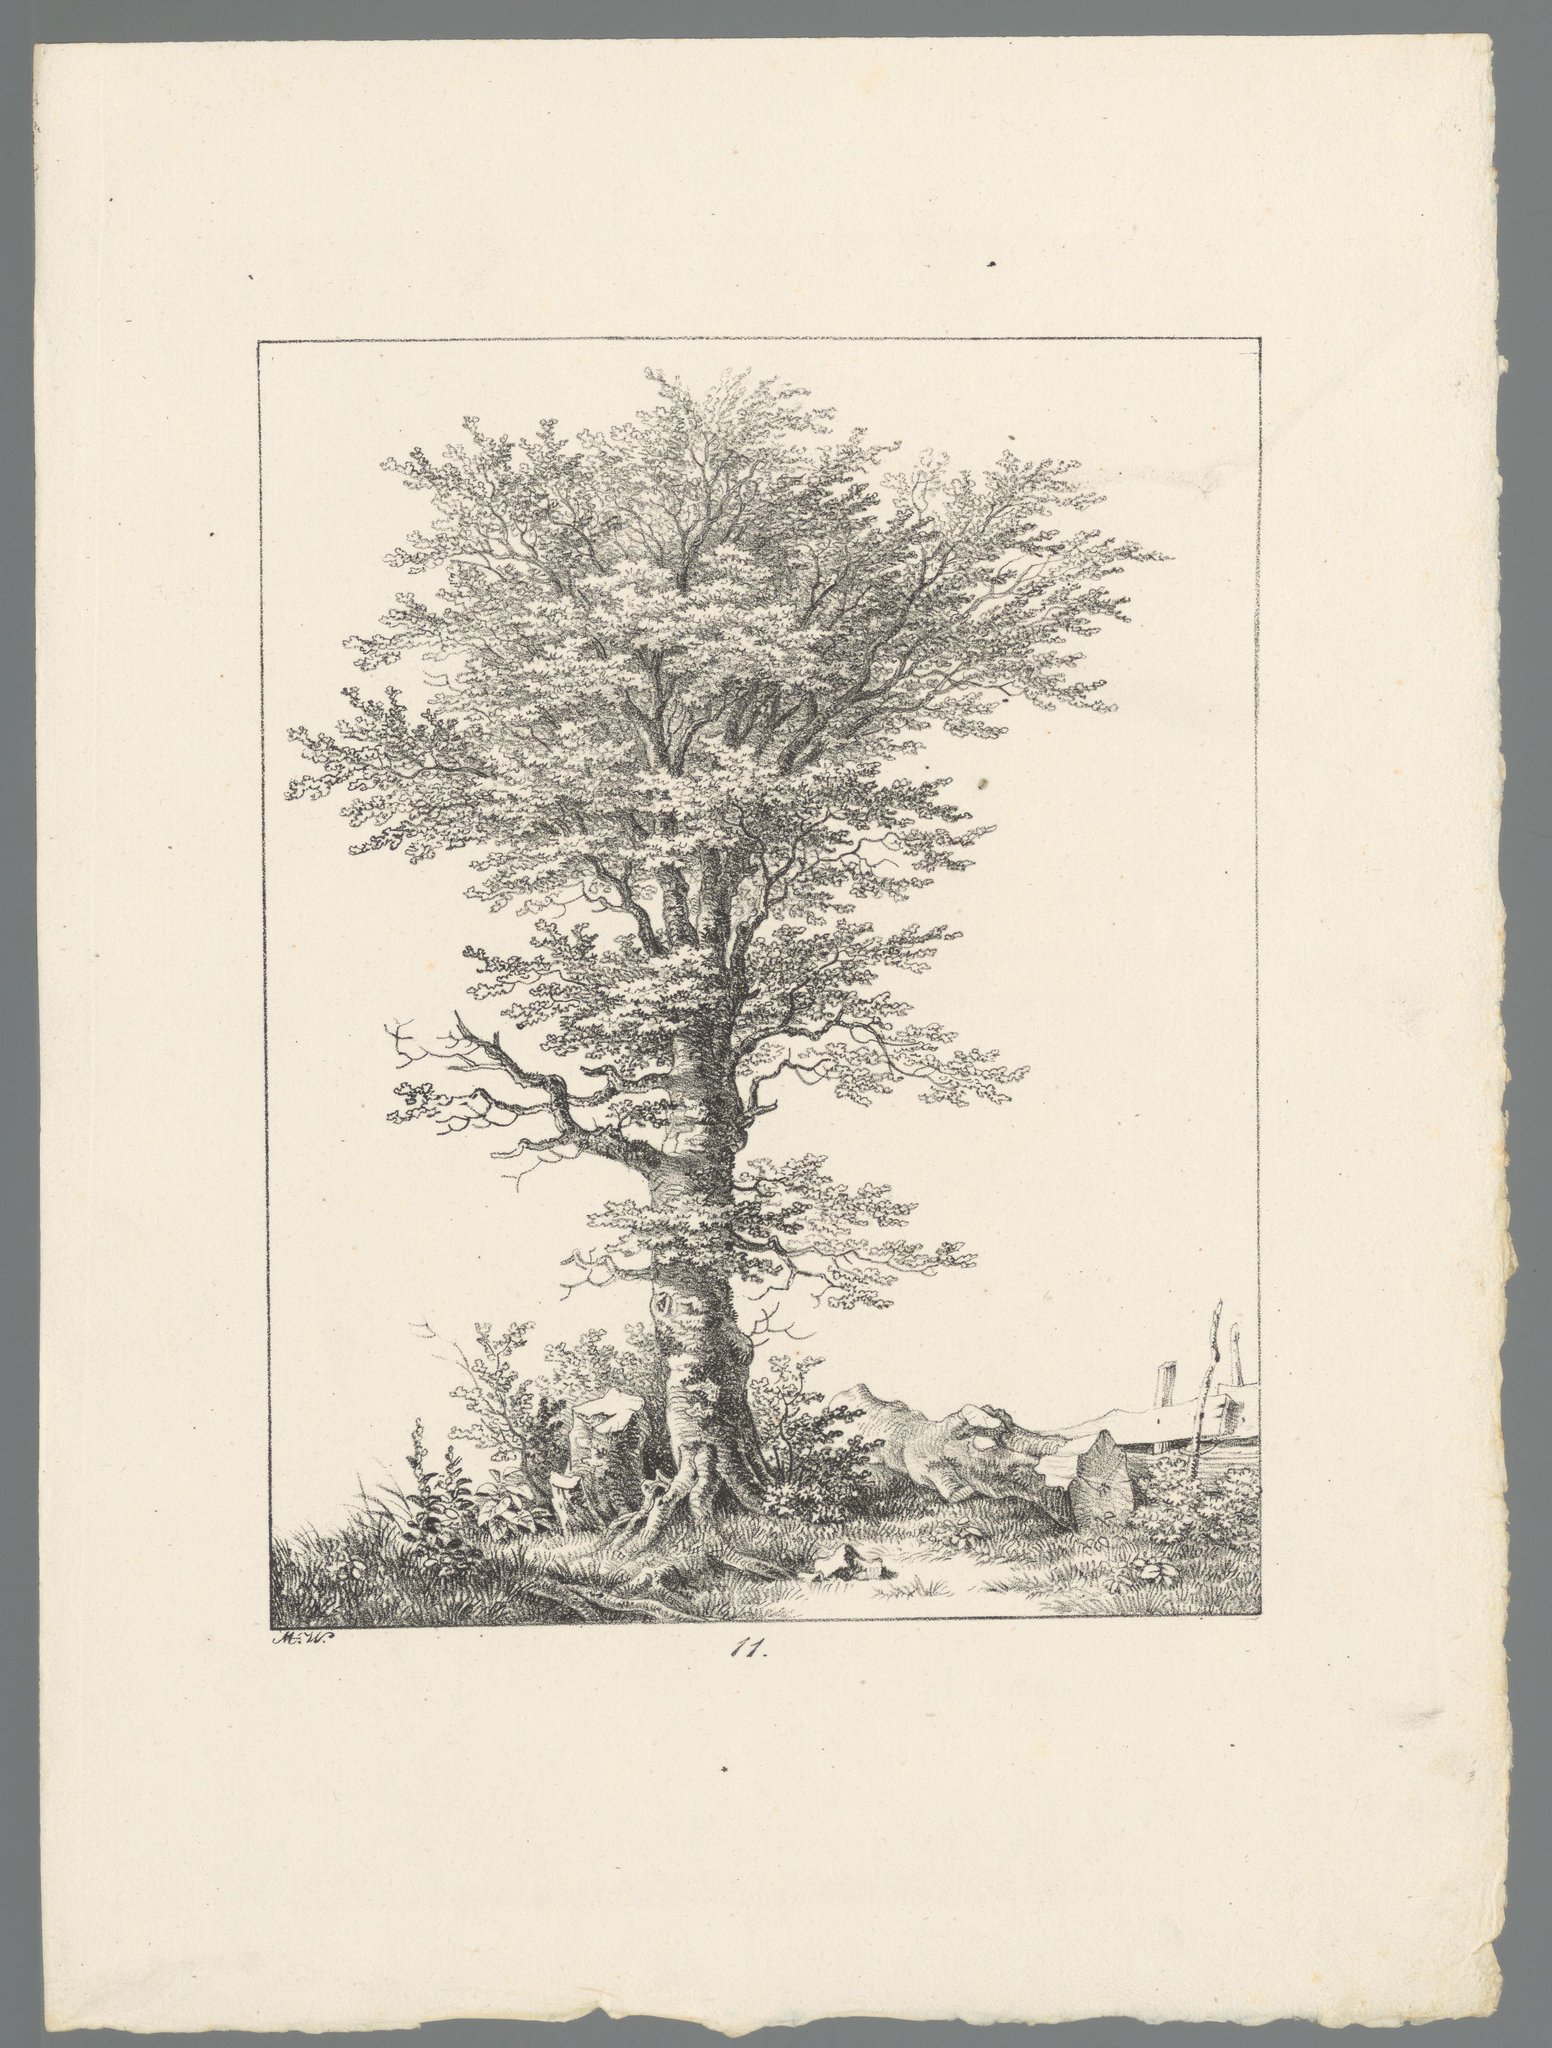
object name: print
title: Vorlagen für Landschaft-zeichner, I Heft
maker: max josef wagenbauer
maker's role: print maker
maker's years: 1774-1829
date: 1823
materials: paper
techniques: lithograph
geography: munich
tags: trees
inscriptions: collector's mark: Lugt 2228, collector's mark: Lugt 2760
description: Prent behoort tot het eerste deel van de serie 'Vorlagen für Landschaft-zeichner'. Dit eerste deel bevat twintig prenten.